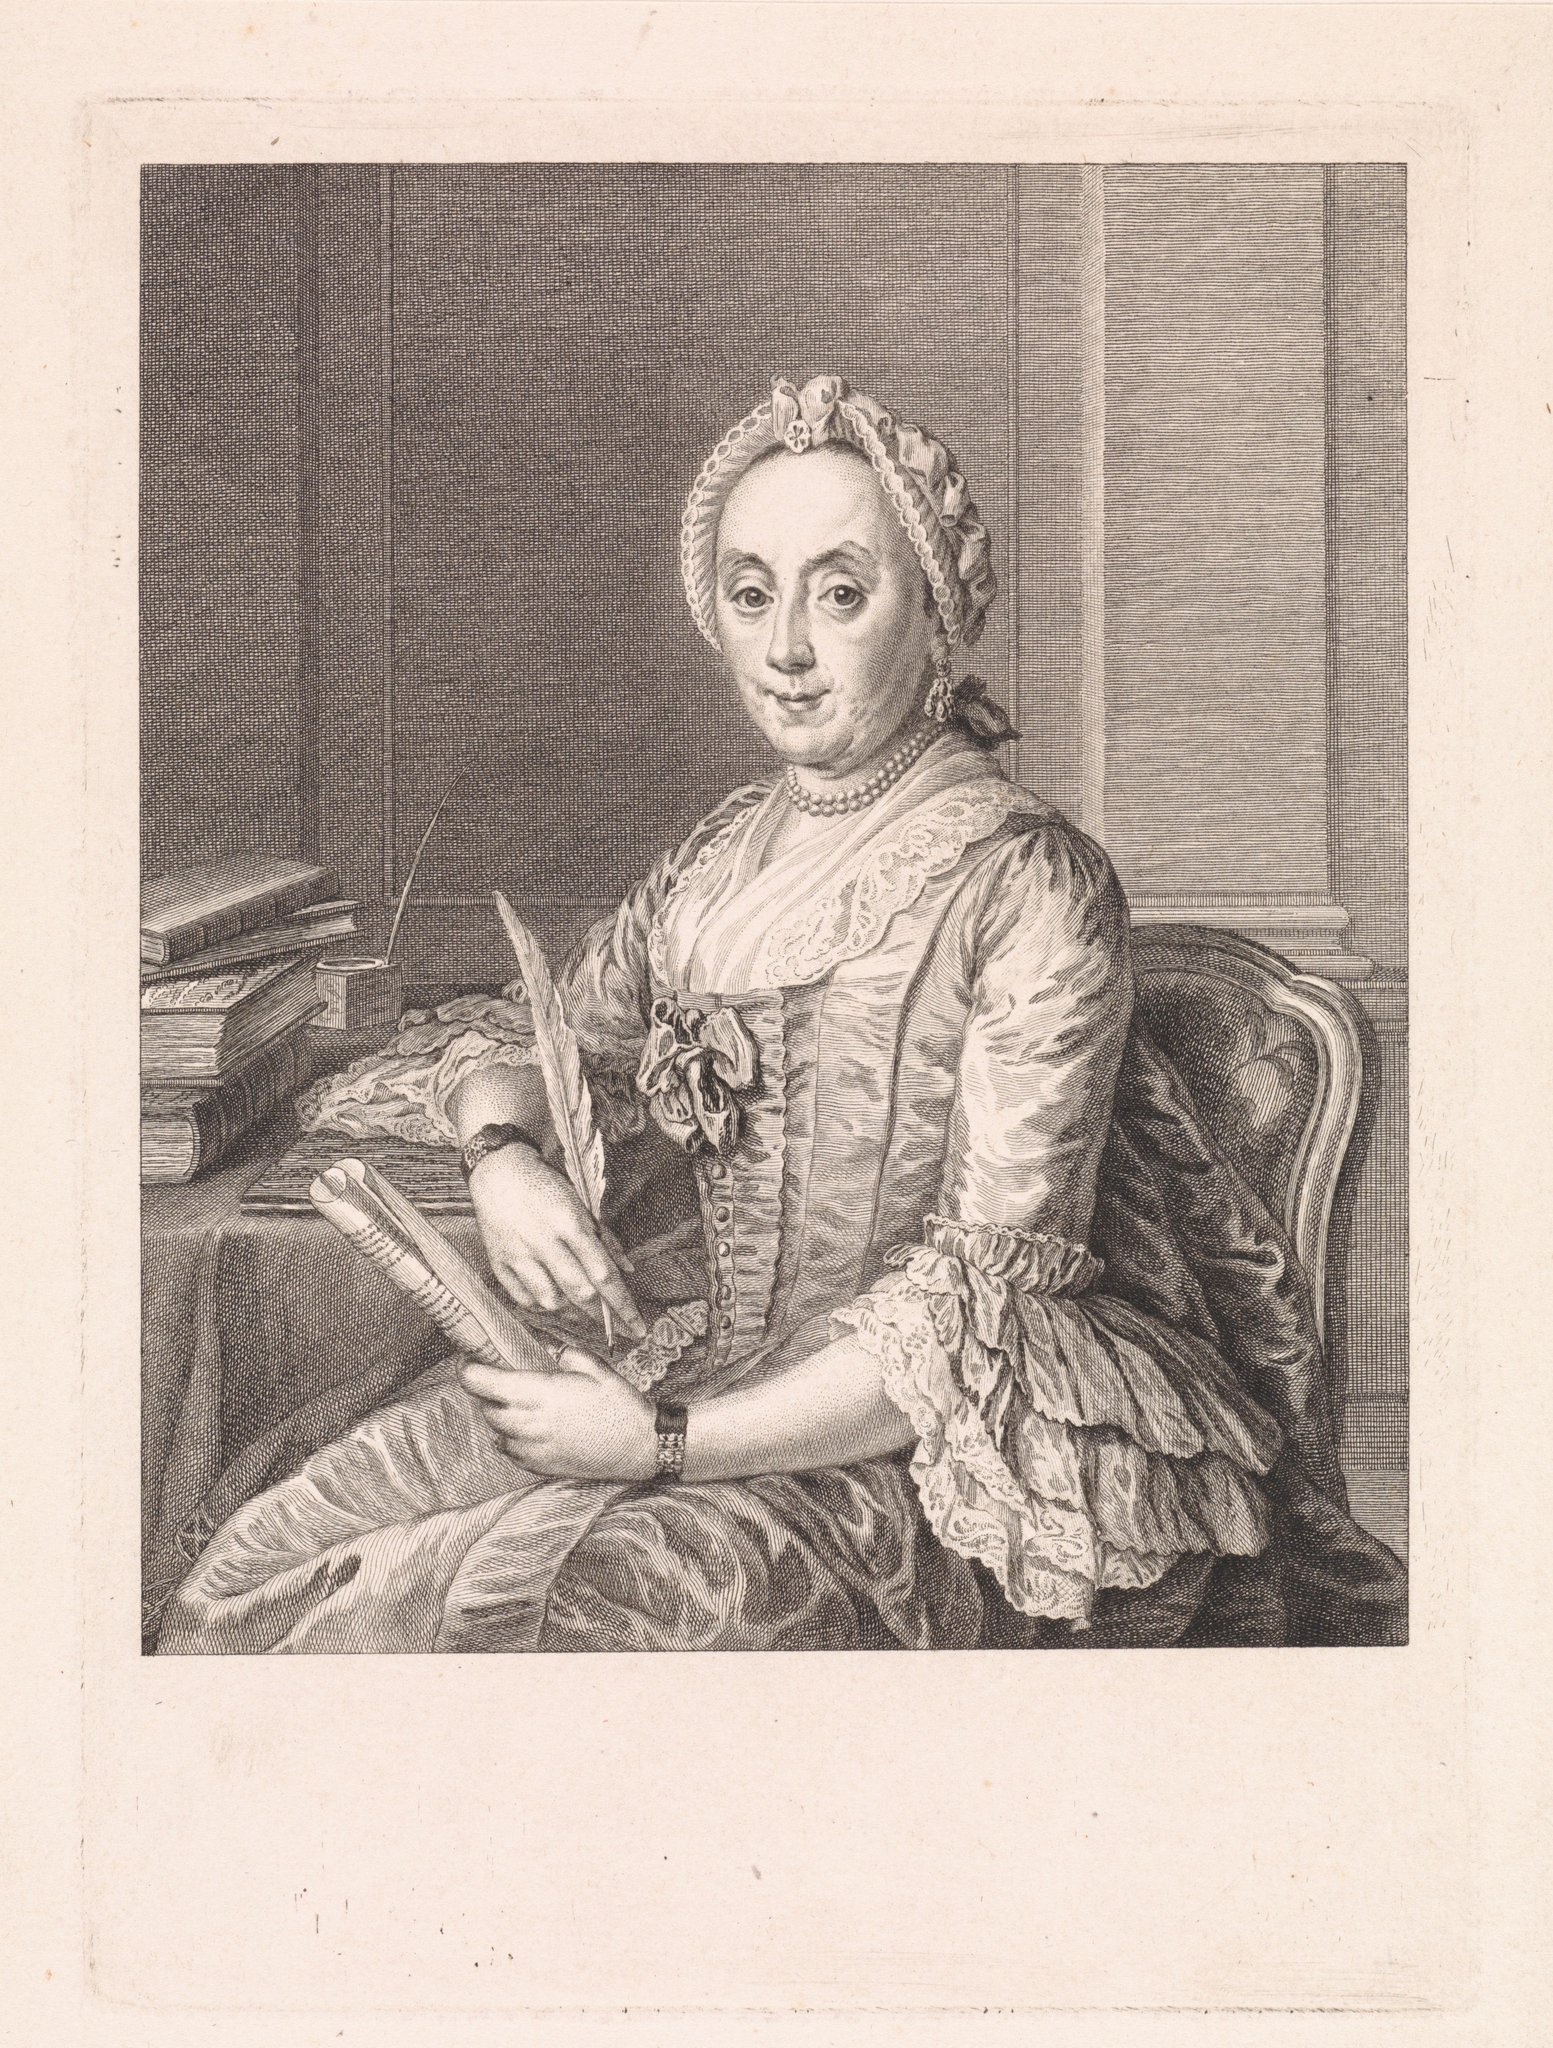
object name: print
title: Portret van Sara Maria van der Wilp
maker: reinier vinkeles (i)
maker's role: draughtsman, print maker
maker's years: 1741-1816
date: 1772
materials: paper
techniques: engraving, etching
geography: amsterdam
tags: amsterdam, sara maria van der wilp, quill, ink-well, paper (writing material)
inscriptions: collector's mark: Lugt 2228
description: Portret van de dichteres Sara Maria van der Wilp. Zij zit op een stoel en haar arm leunt op een tafel. In haar handen heeft zij een rol beschreven papier en een schrijfveer. Op tafel staat een inktpot naast een stapel boeken.